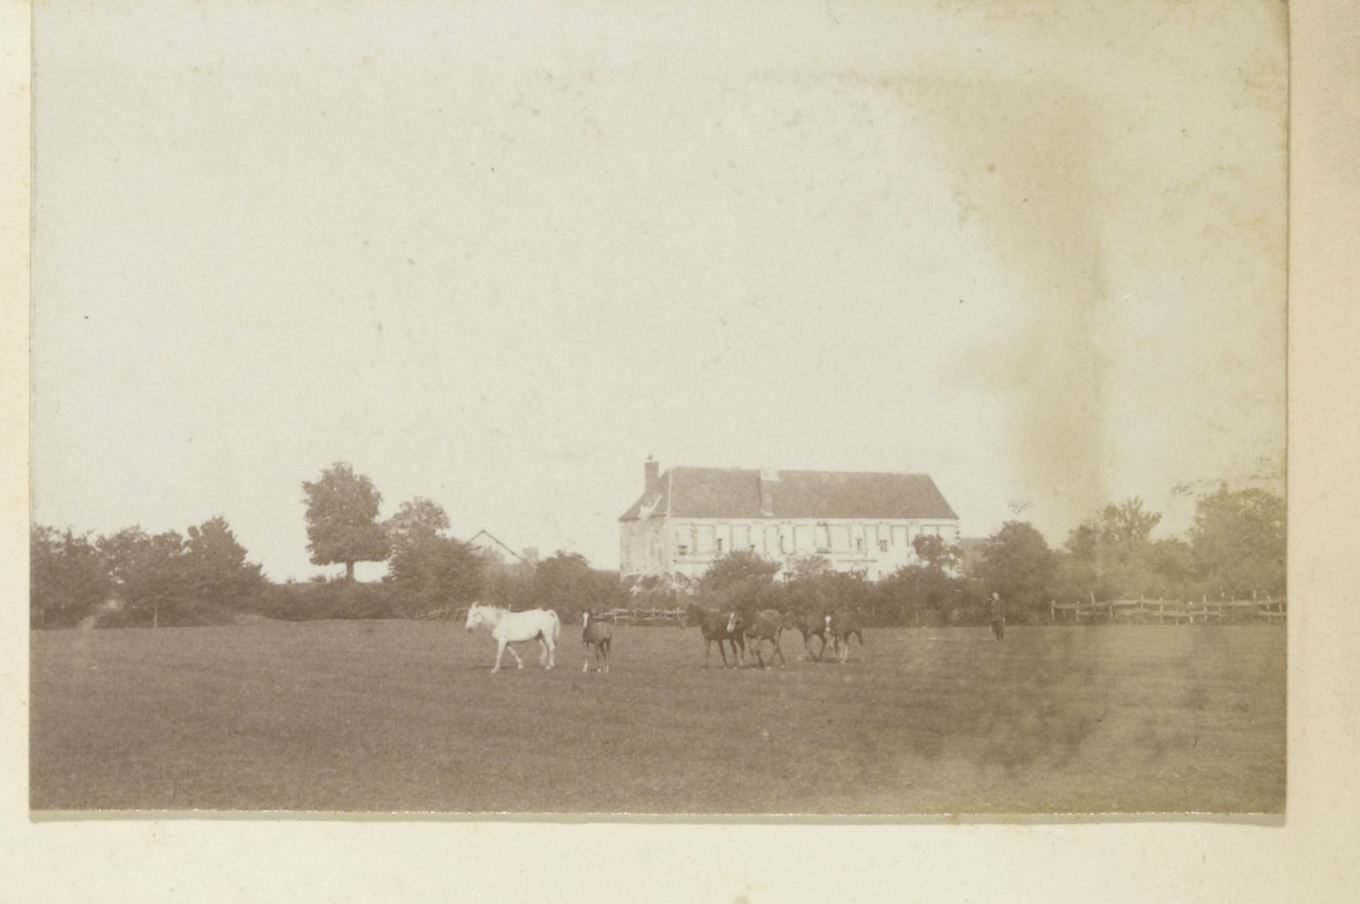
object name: photograph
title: Paarden in een wei in Frankrijk met op de achtergrond een landhuis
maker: Anonymous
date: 1900-1910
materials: paper, photographic support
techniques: albumen print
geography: france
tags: meadow, pasture, rural housing, e.g. country-house, villa, cottage, horse, france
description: Onderdeel van Fotoalbum van een Franse amateurfotograaf met opnames van een familie, distilleerderij Delizy & Doistau Fils, het leger en bezienswaardigheden in Frankrijk.